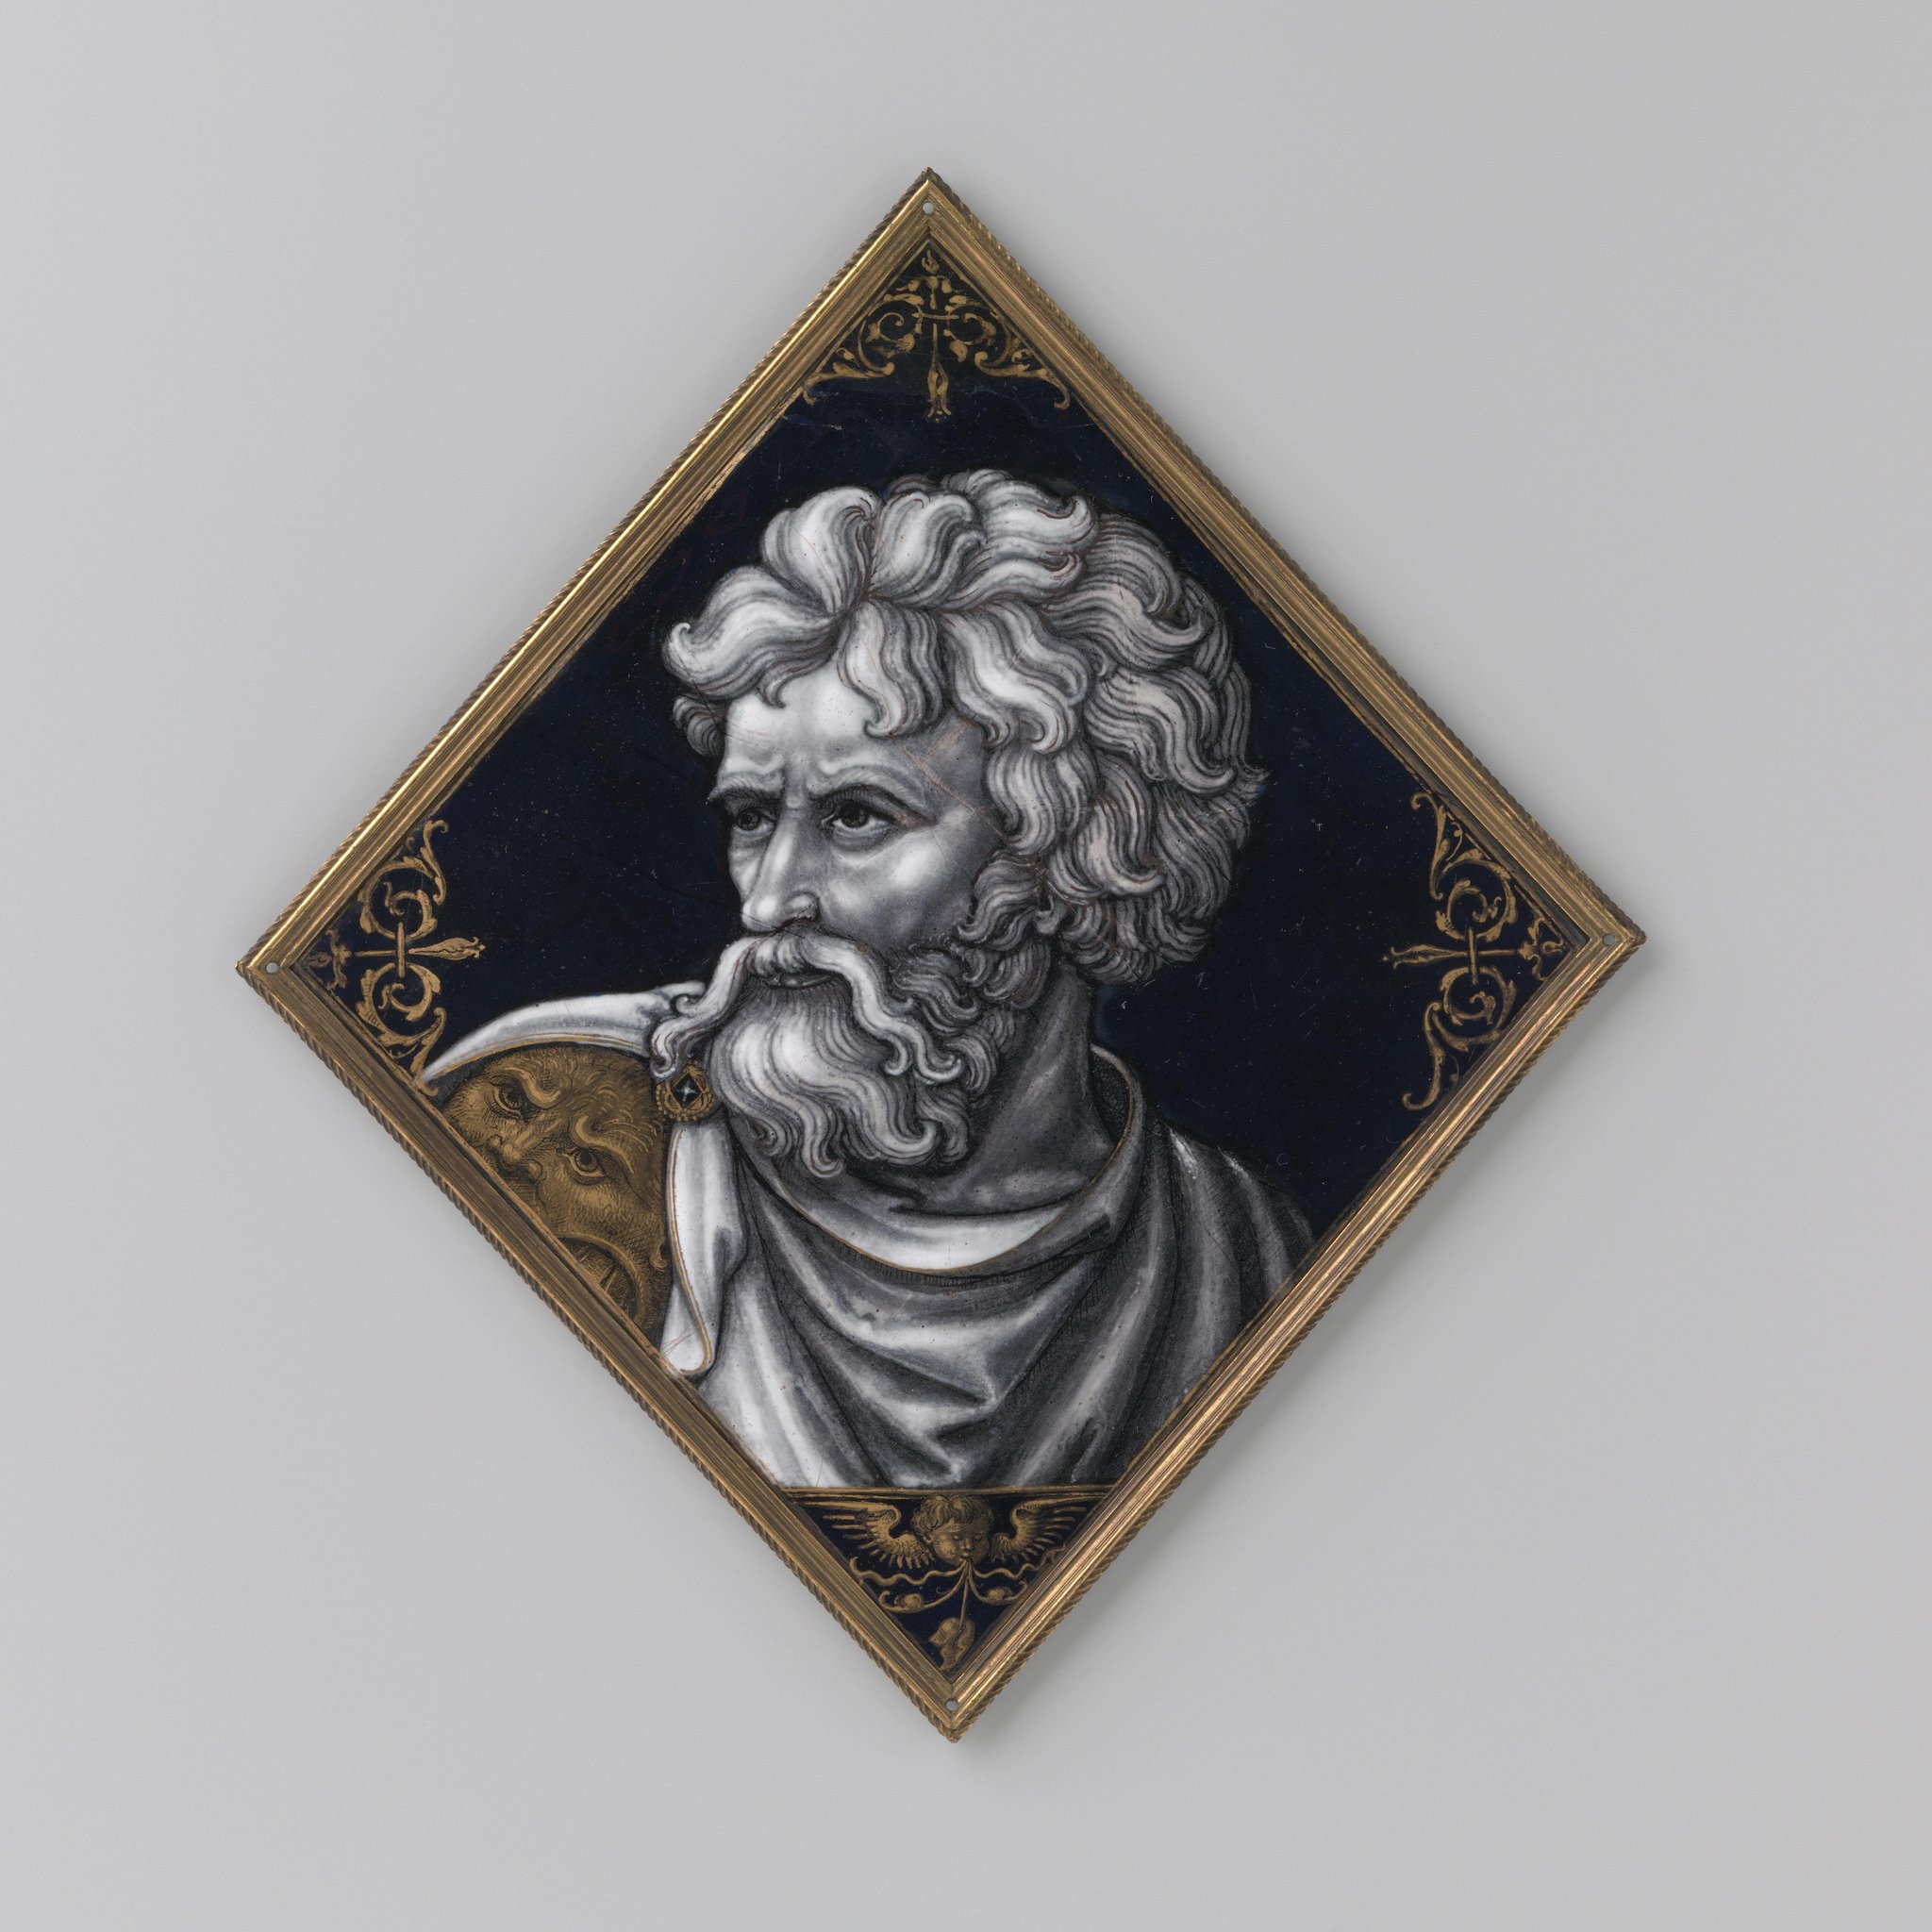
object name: plaque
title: Two plaques with busts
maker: Anonymous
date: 1540-1560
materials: copper, gold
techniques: gilding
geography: limoges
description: In the 16th century, artists often combined individual enamel plaques to form large tableaux. The particular form of these examples suggests they may have been intended to fill a corner. It was not unusual for classical gods or ancient heroes to appear in support of the message in the principal scene: often they would symbolize one of the virtues.